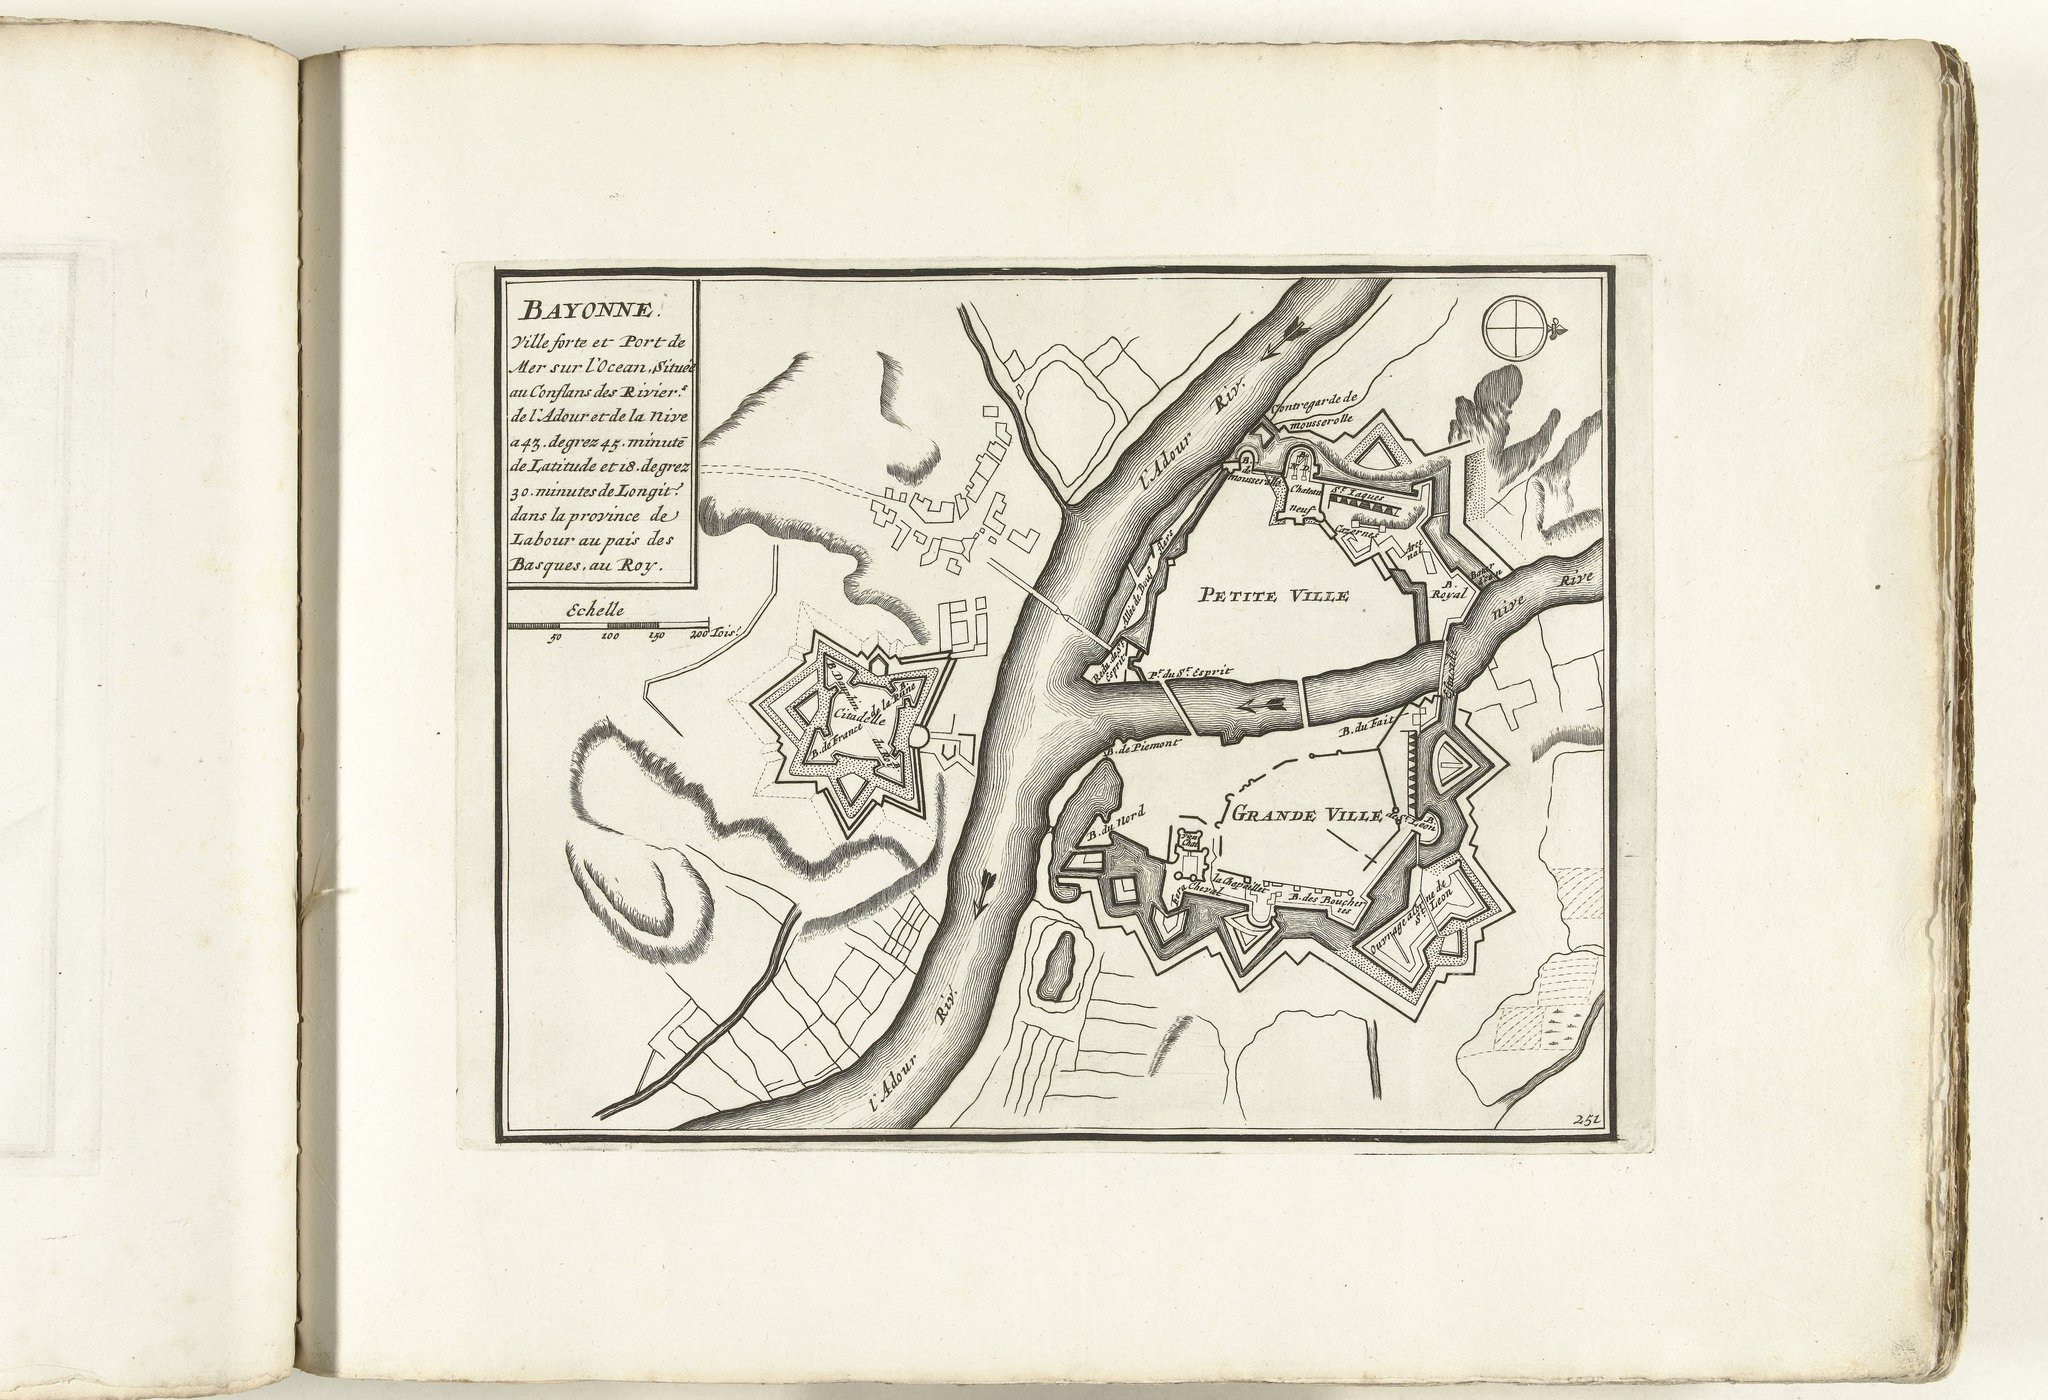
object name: print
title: Bayonne. Ville forte et Port de Mer (...)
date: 1702-1703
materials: paper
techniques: engraving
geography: northern netherlands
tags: fortress, maps of cities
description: Plattegrond van de versterkingen om de Franse stad Bayonne. Plaat nr. 251 in het prentwerk bestaande in totaal uit 276 genummerde platen van vermaarde sterke steden en vestingen in het kader van de Spaanse Successieoorlog. Voor het merendeel zijn deze platen gekopieerd naar de anonieme Franse platen: in Les forces de l'Europe en in: Le theatre de la guerre, dans les Pays-Bas, beide oorspronkelijk uitgegeven door Nicolas de Fer te Parijs (1693-1697) in het kader van de Negenjarige Oorlog. Titel en opschriften in de plaat in het Frans.